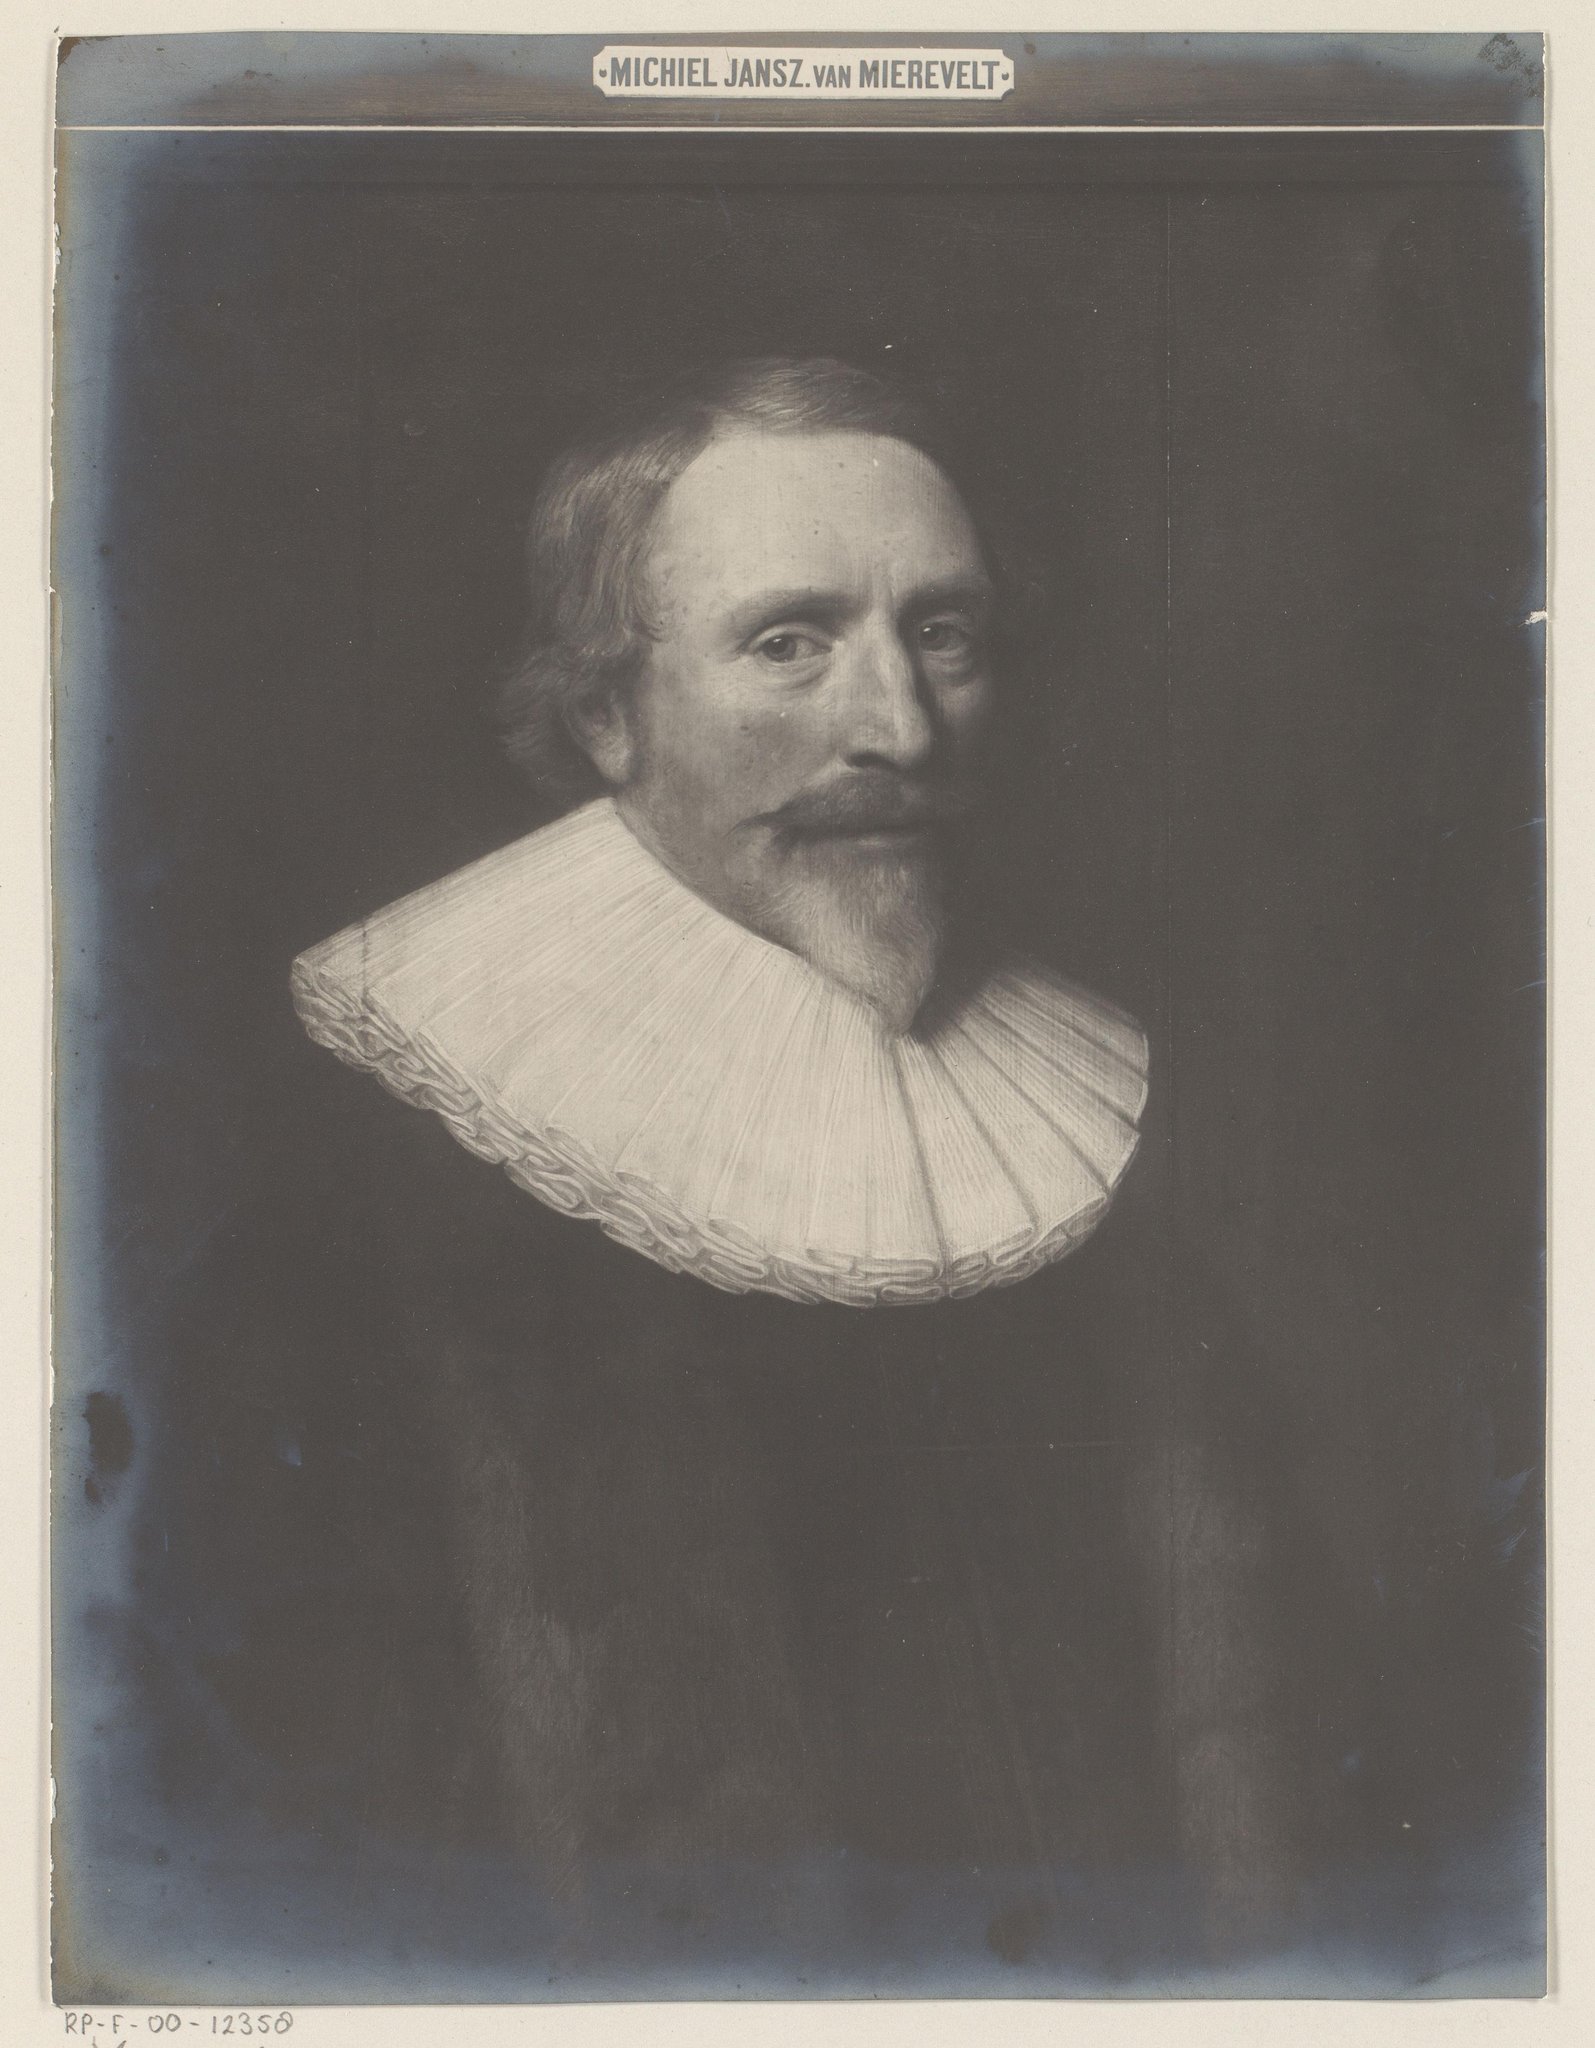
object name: reproduction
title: Fotoreproductie van een geschilderd portret van Jacob Cats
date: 1912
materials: paper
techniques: gelatin silver print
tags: the hague, jacob cats (1577-1660), historical persons, portrait of a writer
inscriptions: inscription: ‘No. 1584/ Jacob Cats/ RM/ Van Leer & CO/ Dec 1912/ Mierevelt’, inscription: ‘'13.’